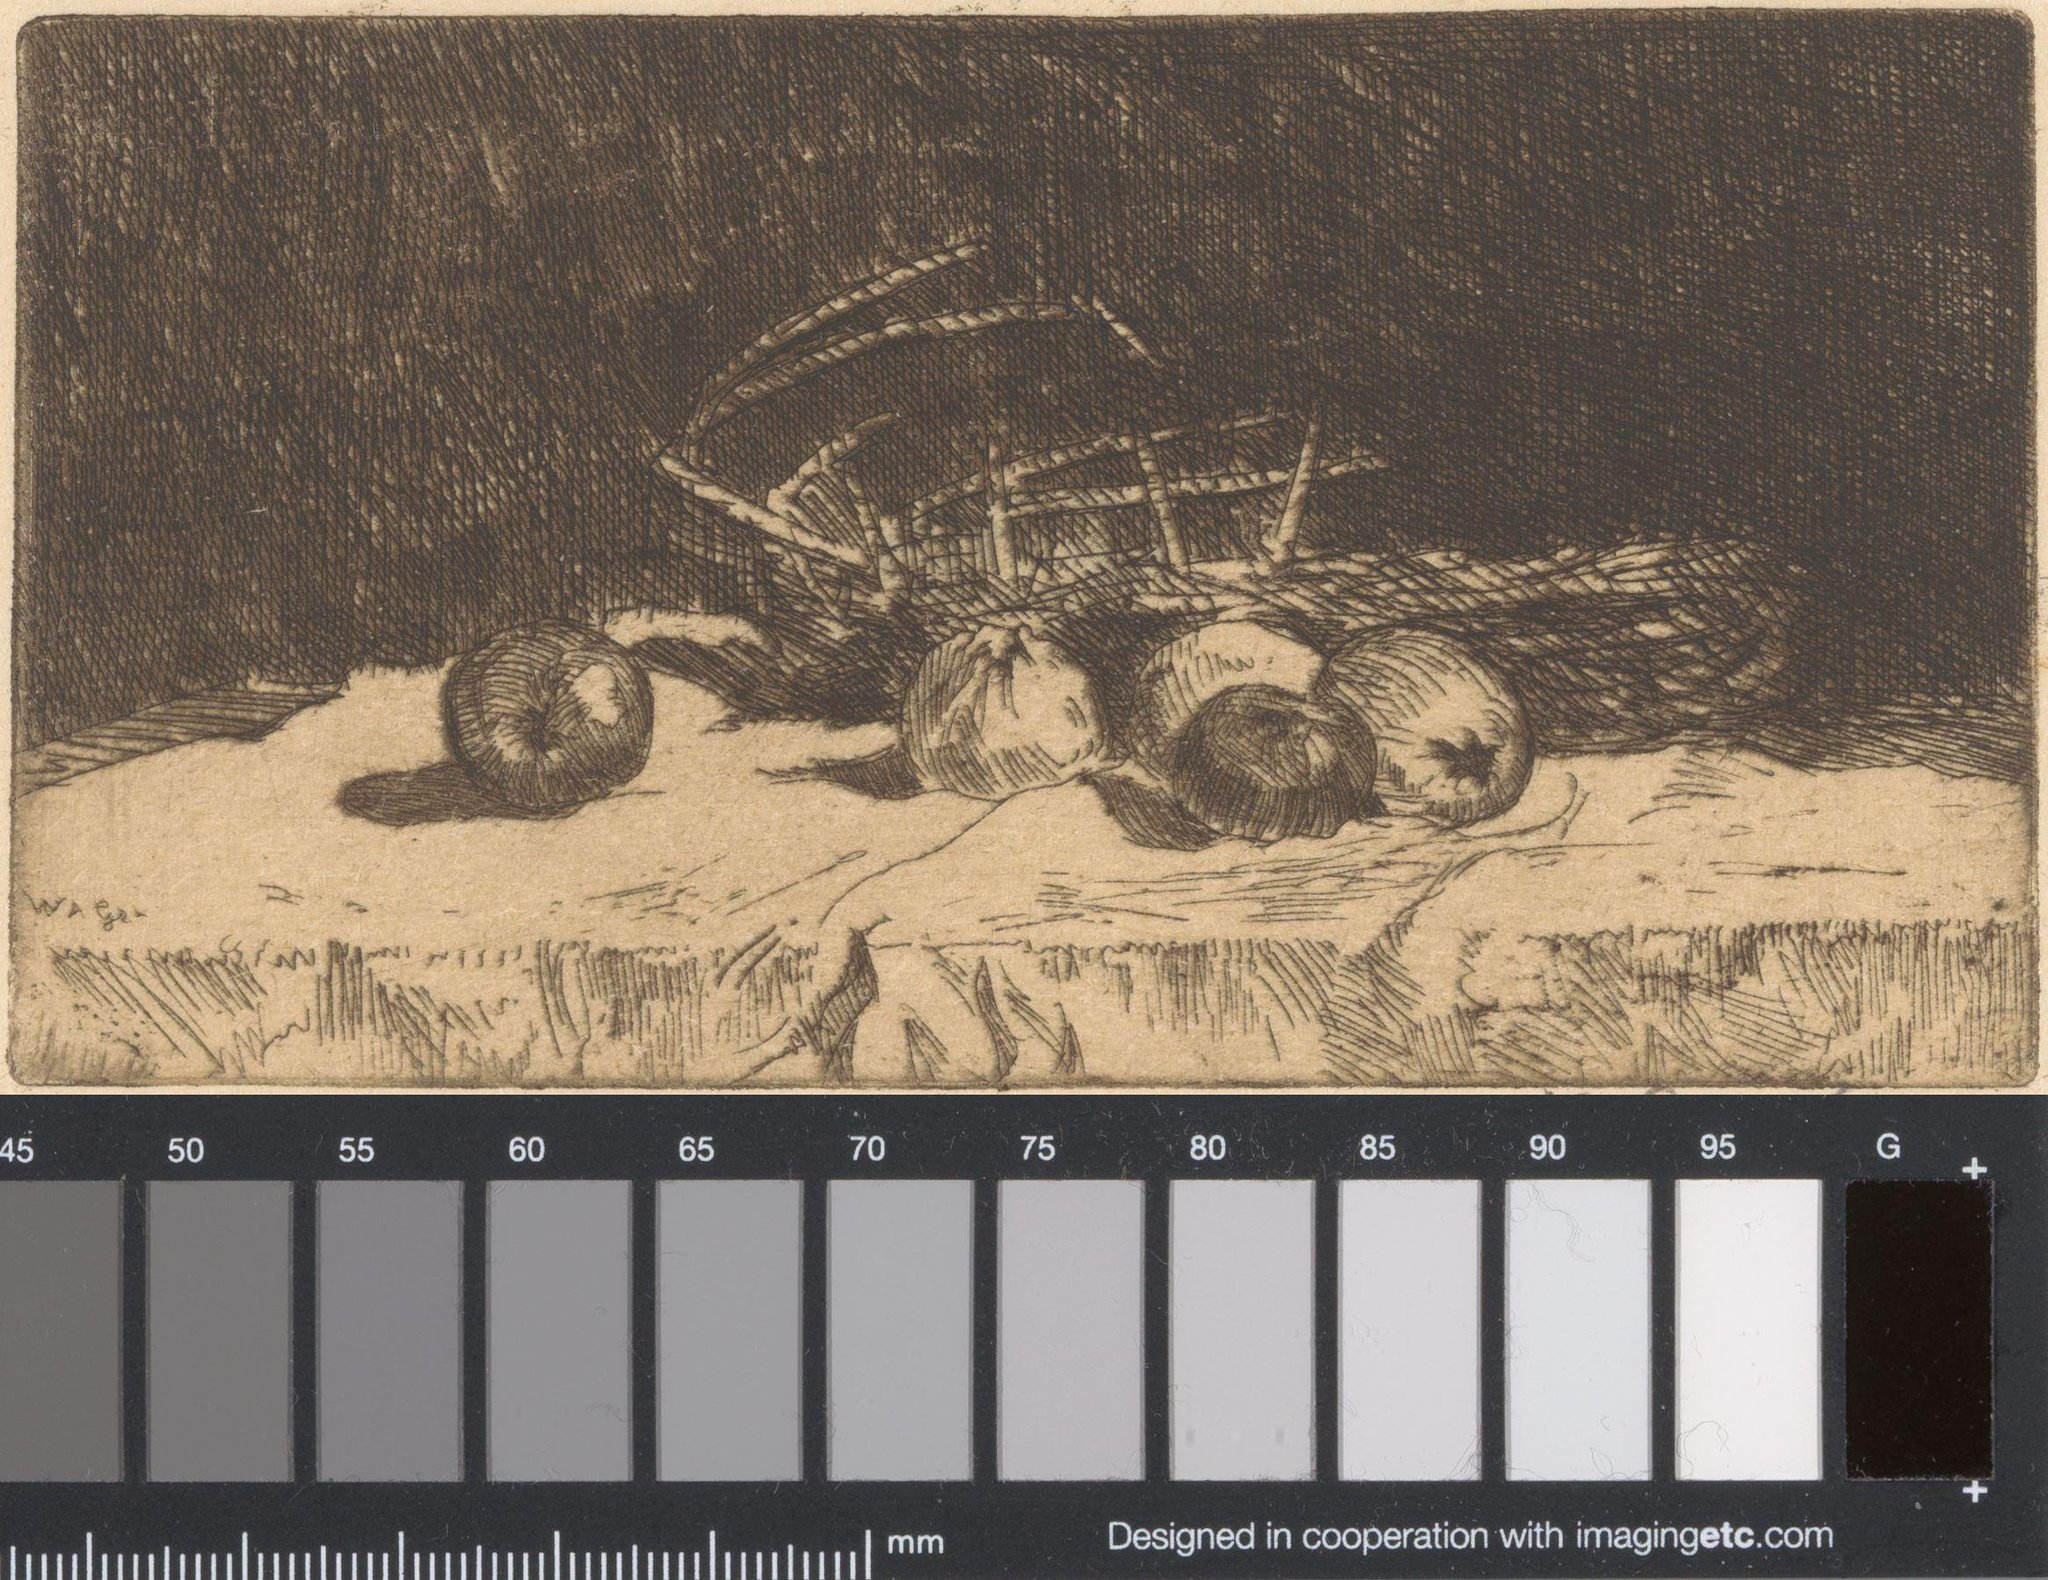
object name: print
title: Stilleven met fruit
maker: willem adrianus grondhout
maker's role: draughtsman, painter, print maker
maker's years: 1878-1934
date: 1888-1934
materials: paper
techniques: etching, intaglio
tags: foodstuffs; still life of foodstuffs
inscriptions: collector's mark: Lugt 2228